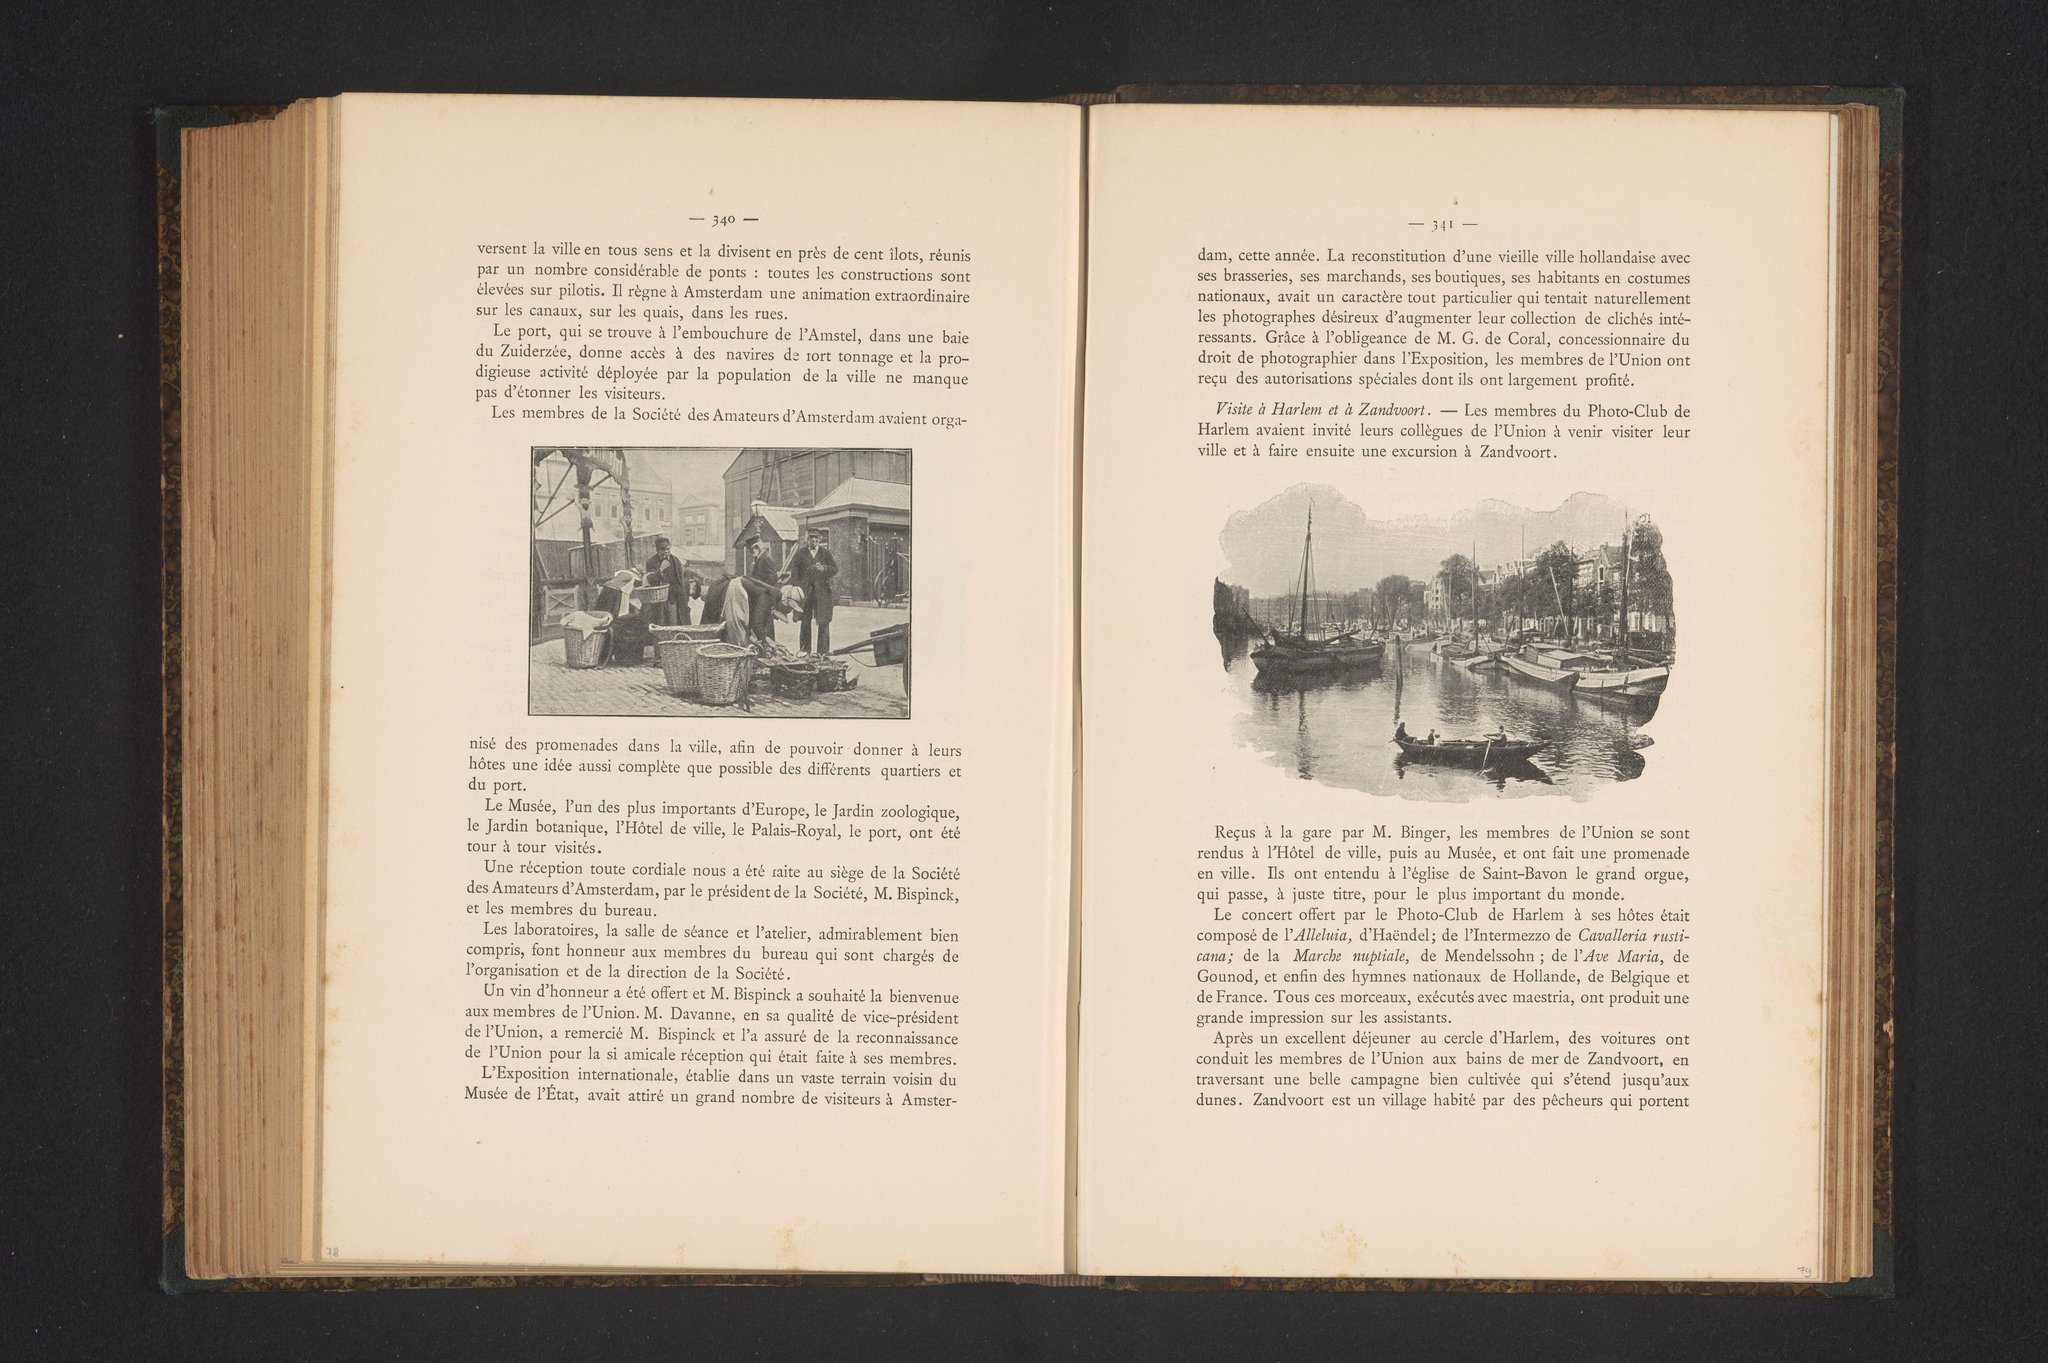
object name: photomechanical print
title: Verkoopster van vis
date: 1890-1895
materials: paper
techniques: autotype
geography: haarlem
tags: merchant, salesman (with name of trade or profession) - bb - women engaged in trade and commerce, haarlem